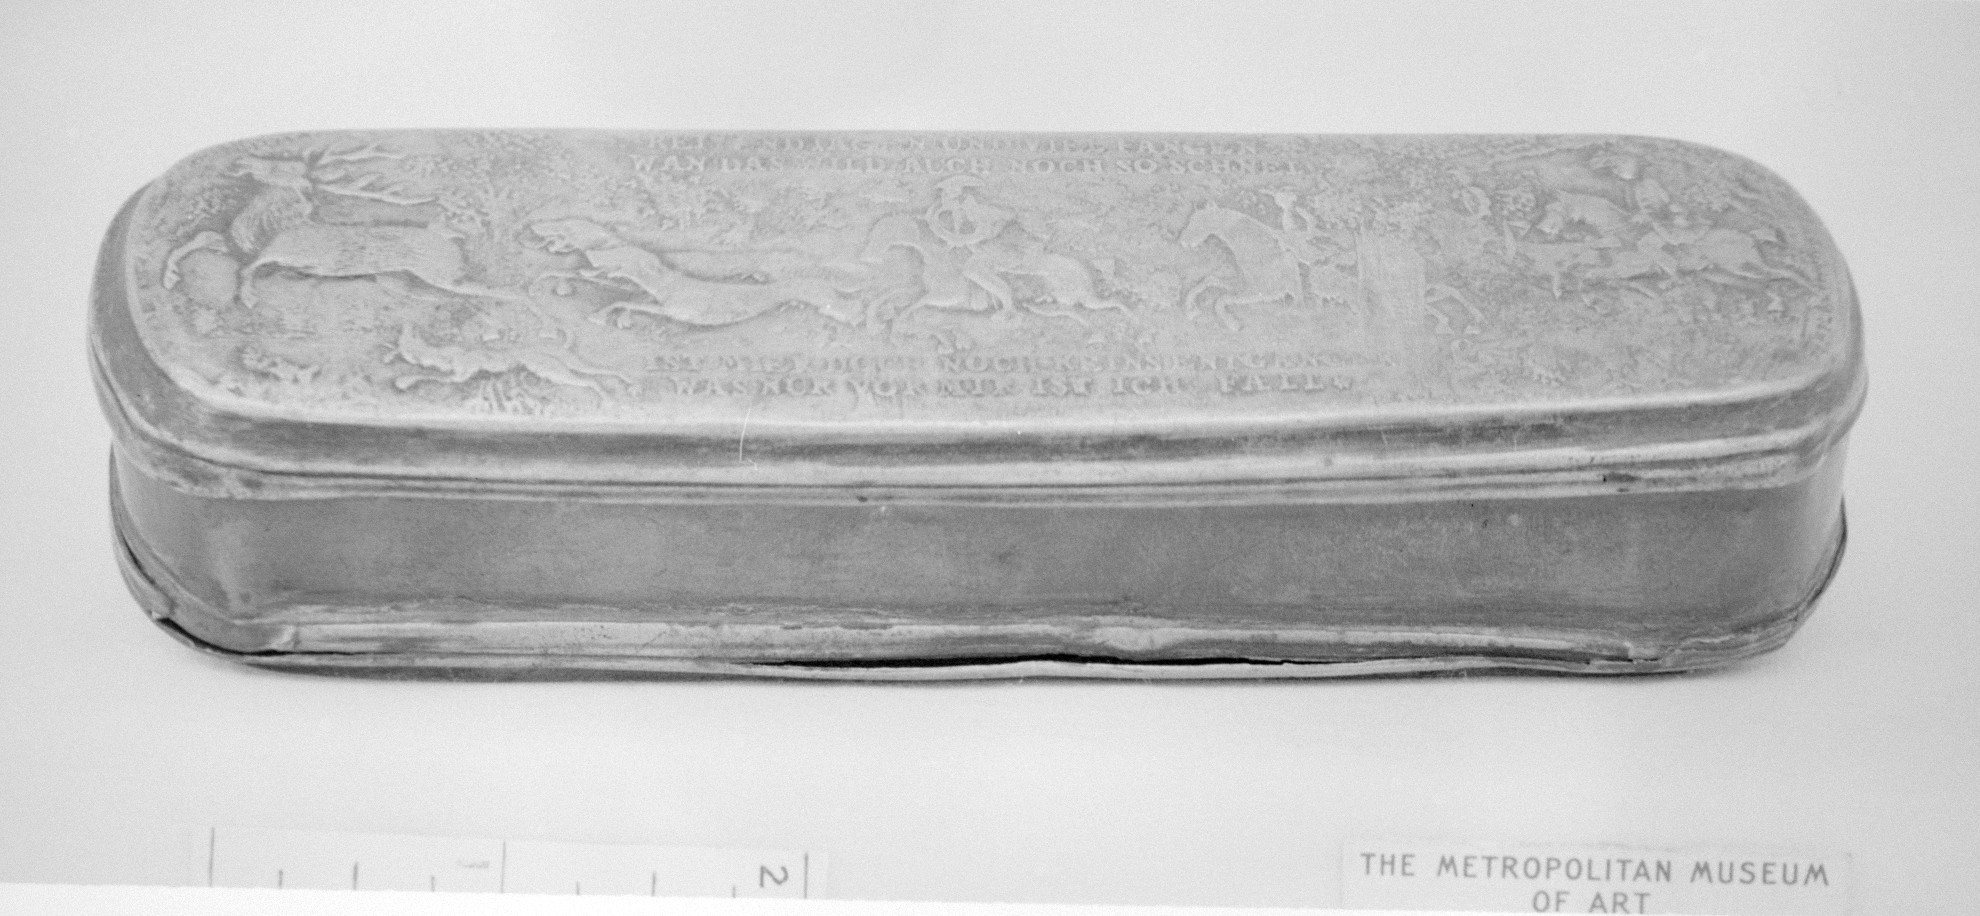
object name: tobacco box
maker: i. h. hamer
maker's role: maker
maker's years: 1700-1800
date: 1760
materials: brass, copper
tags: men,hunting,deer,dogs,horses